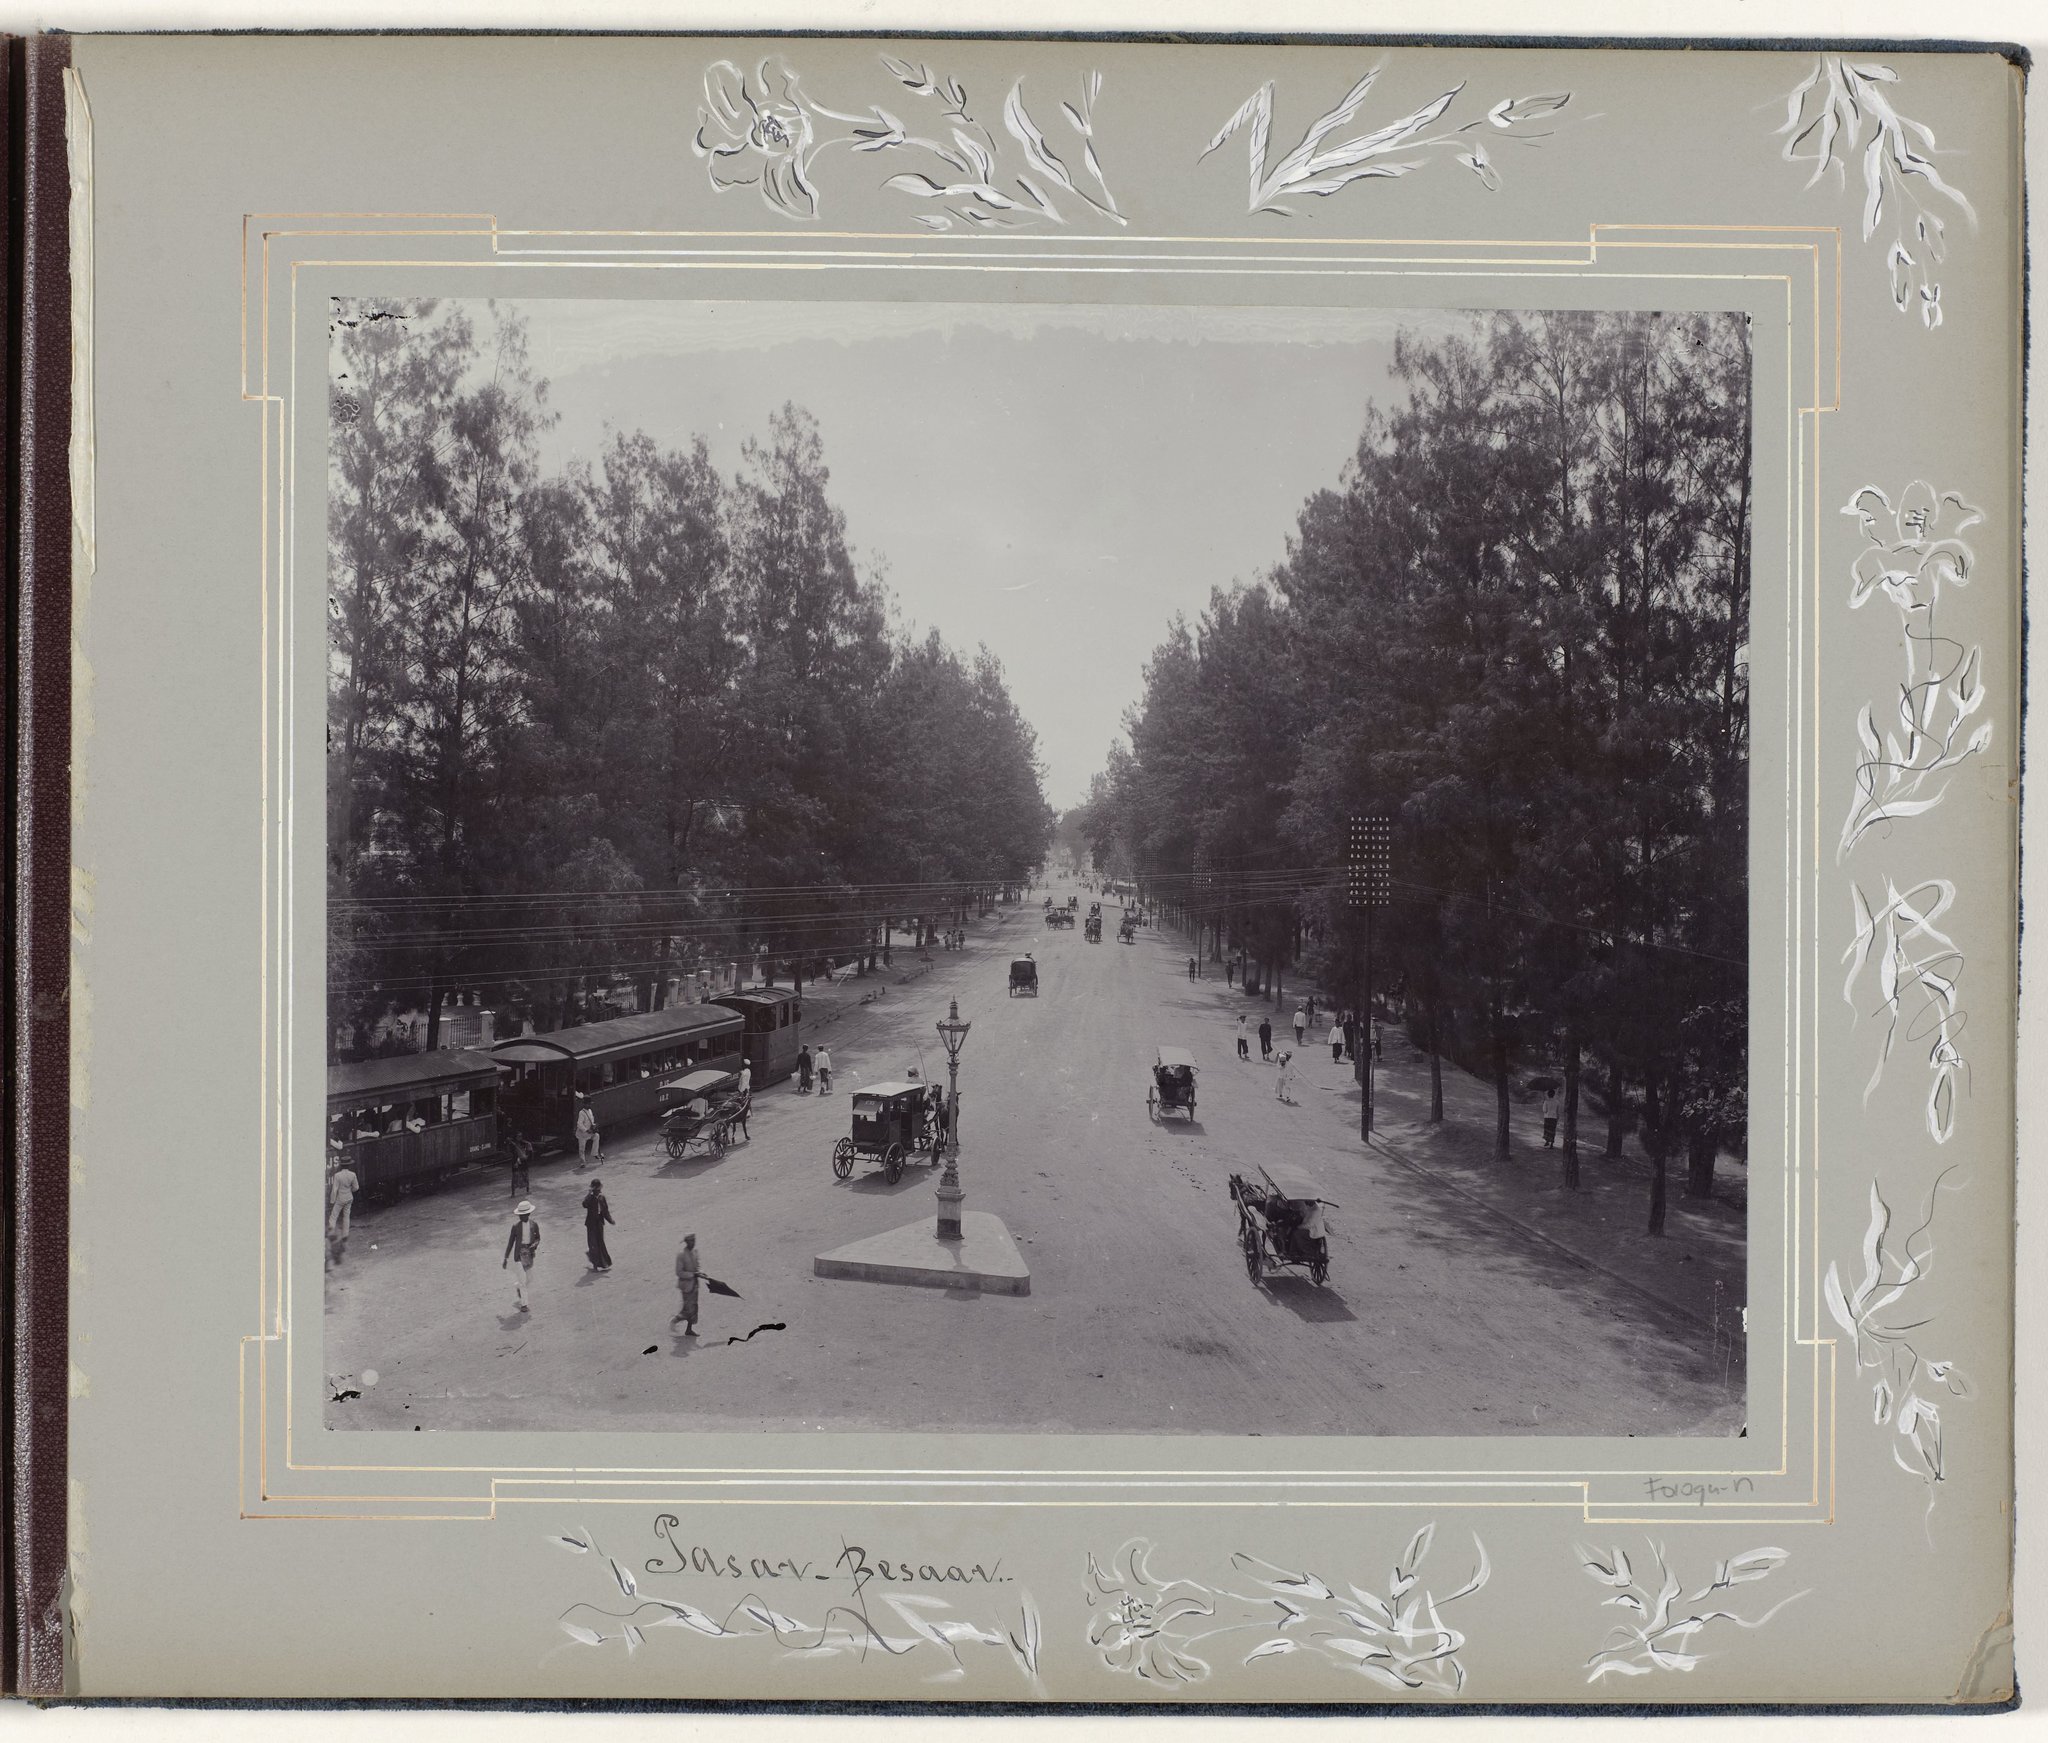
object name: album leaf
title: Pasar-Besaar.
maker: Anonymous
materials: cardboard, paper, photographic support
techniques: gelatin silver print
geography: surabaya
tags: tramway, tram, four-wheeled, animal-drawn vehicle, e.g.: cab, carriage, coach, market, street (+ city(-scape) with figures, staffage), surabaya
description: Onderdeel van Herinneringsalbum met foto's van Soerabaja.